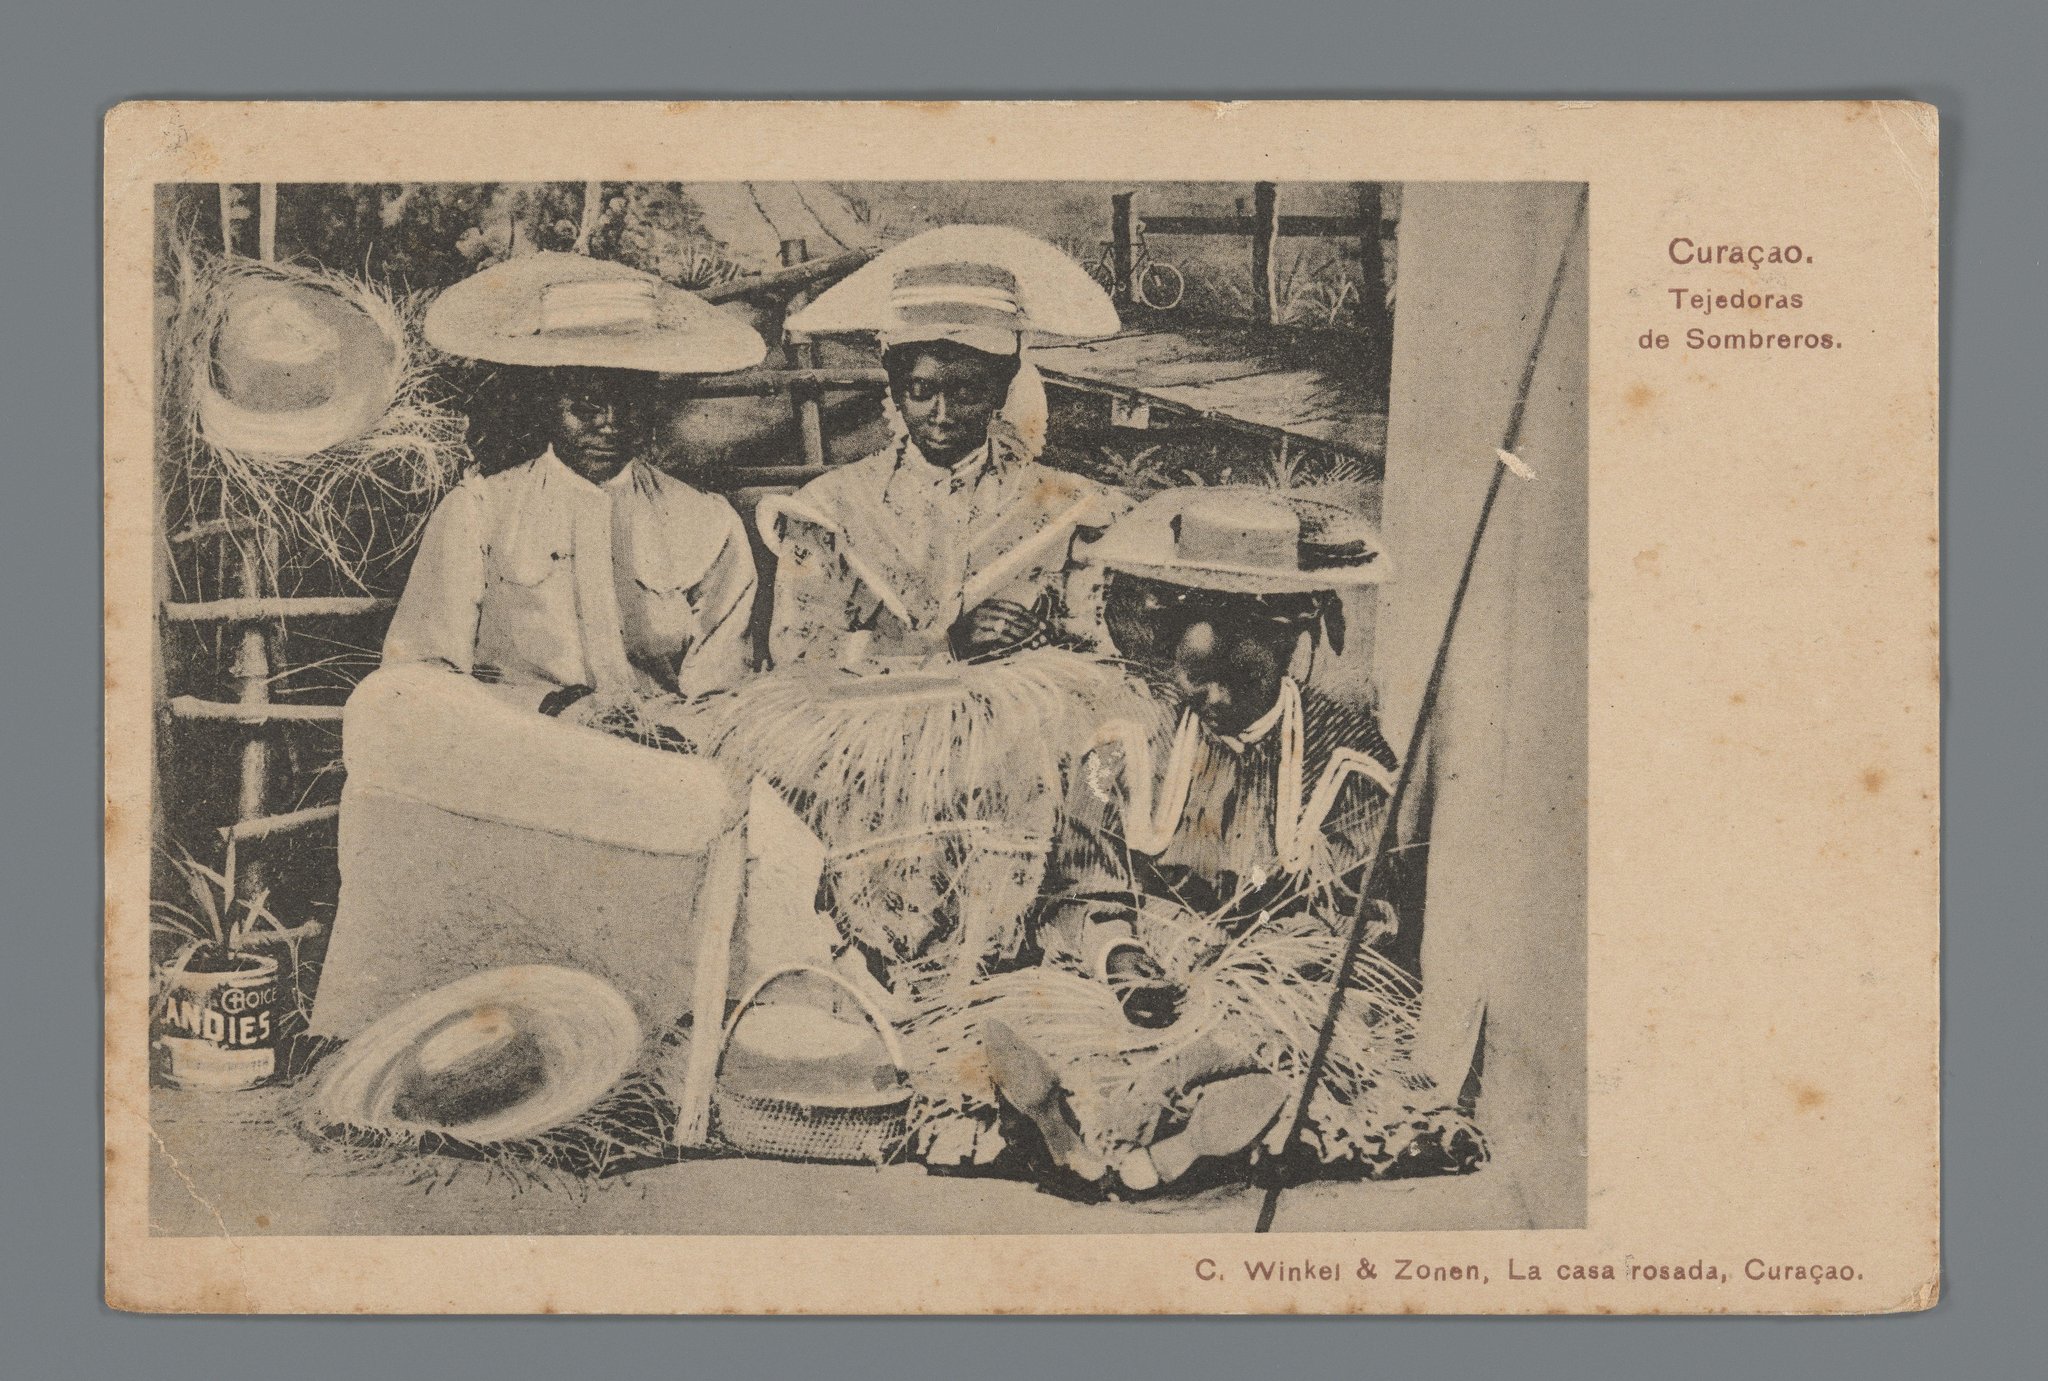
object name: ansichtkaart, prentbriefkaart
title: Curaçao, Tejedoras de Sombreros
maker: Anonymous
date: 1906-1915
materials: cardboard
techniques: photograph, writing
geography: curacao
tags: anonymous historical persons portrayed in a group, in a group-portrait - bb - woman, head-gear (with name)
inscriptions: poststempel, verso, gestempeld